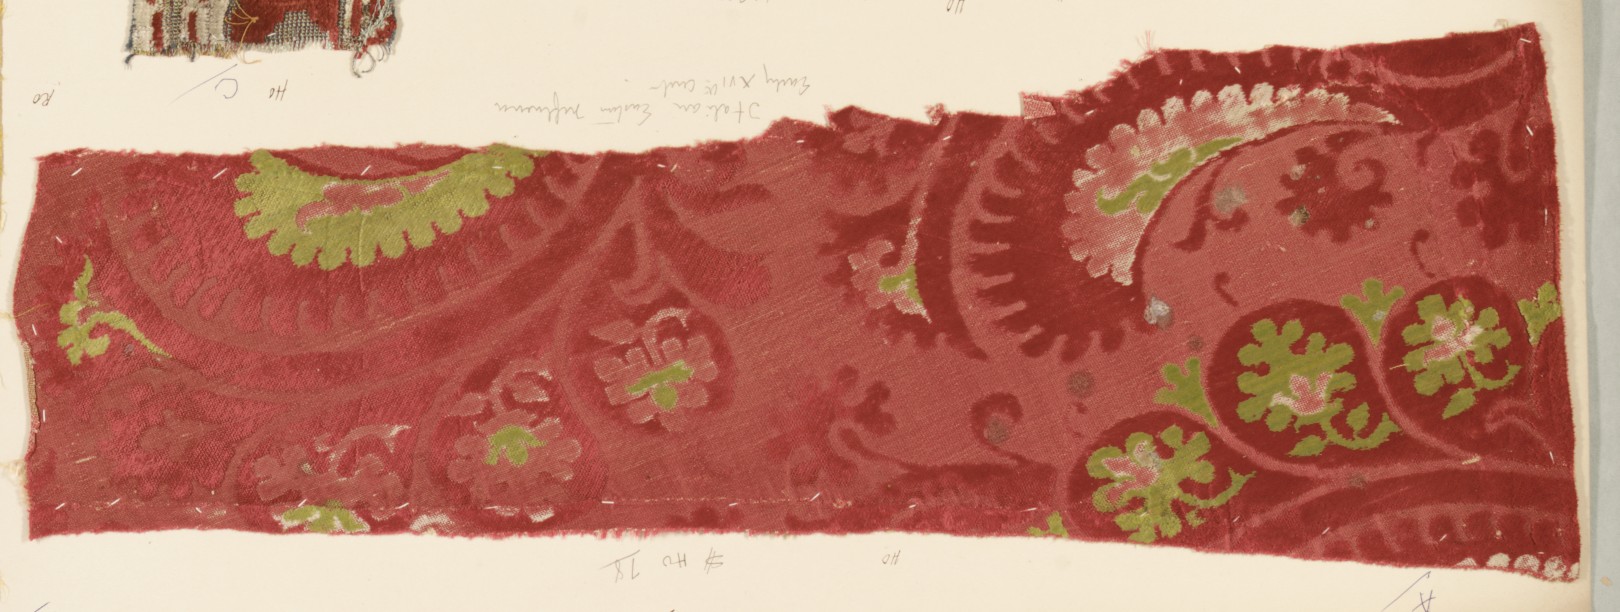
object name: fragment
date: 1401-1500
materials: silk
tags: flowers